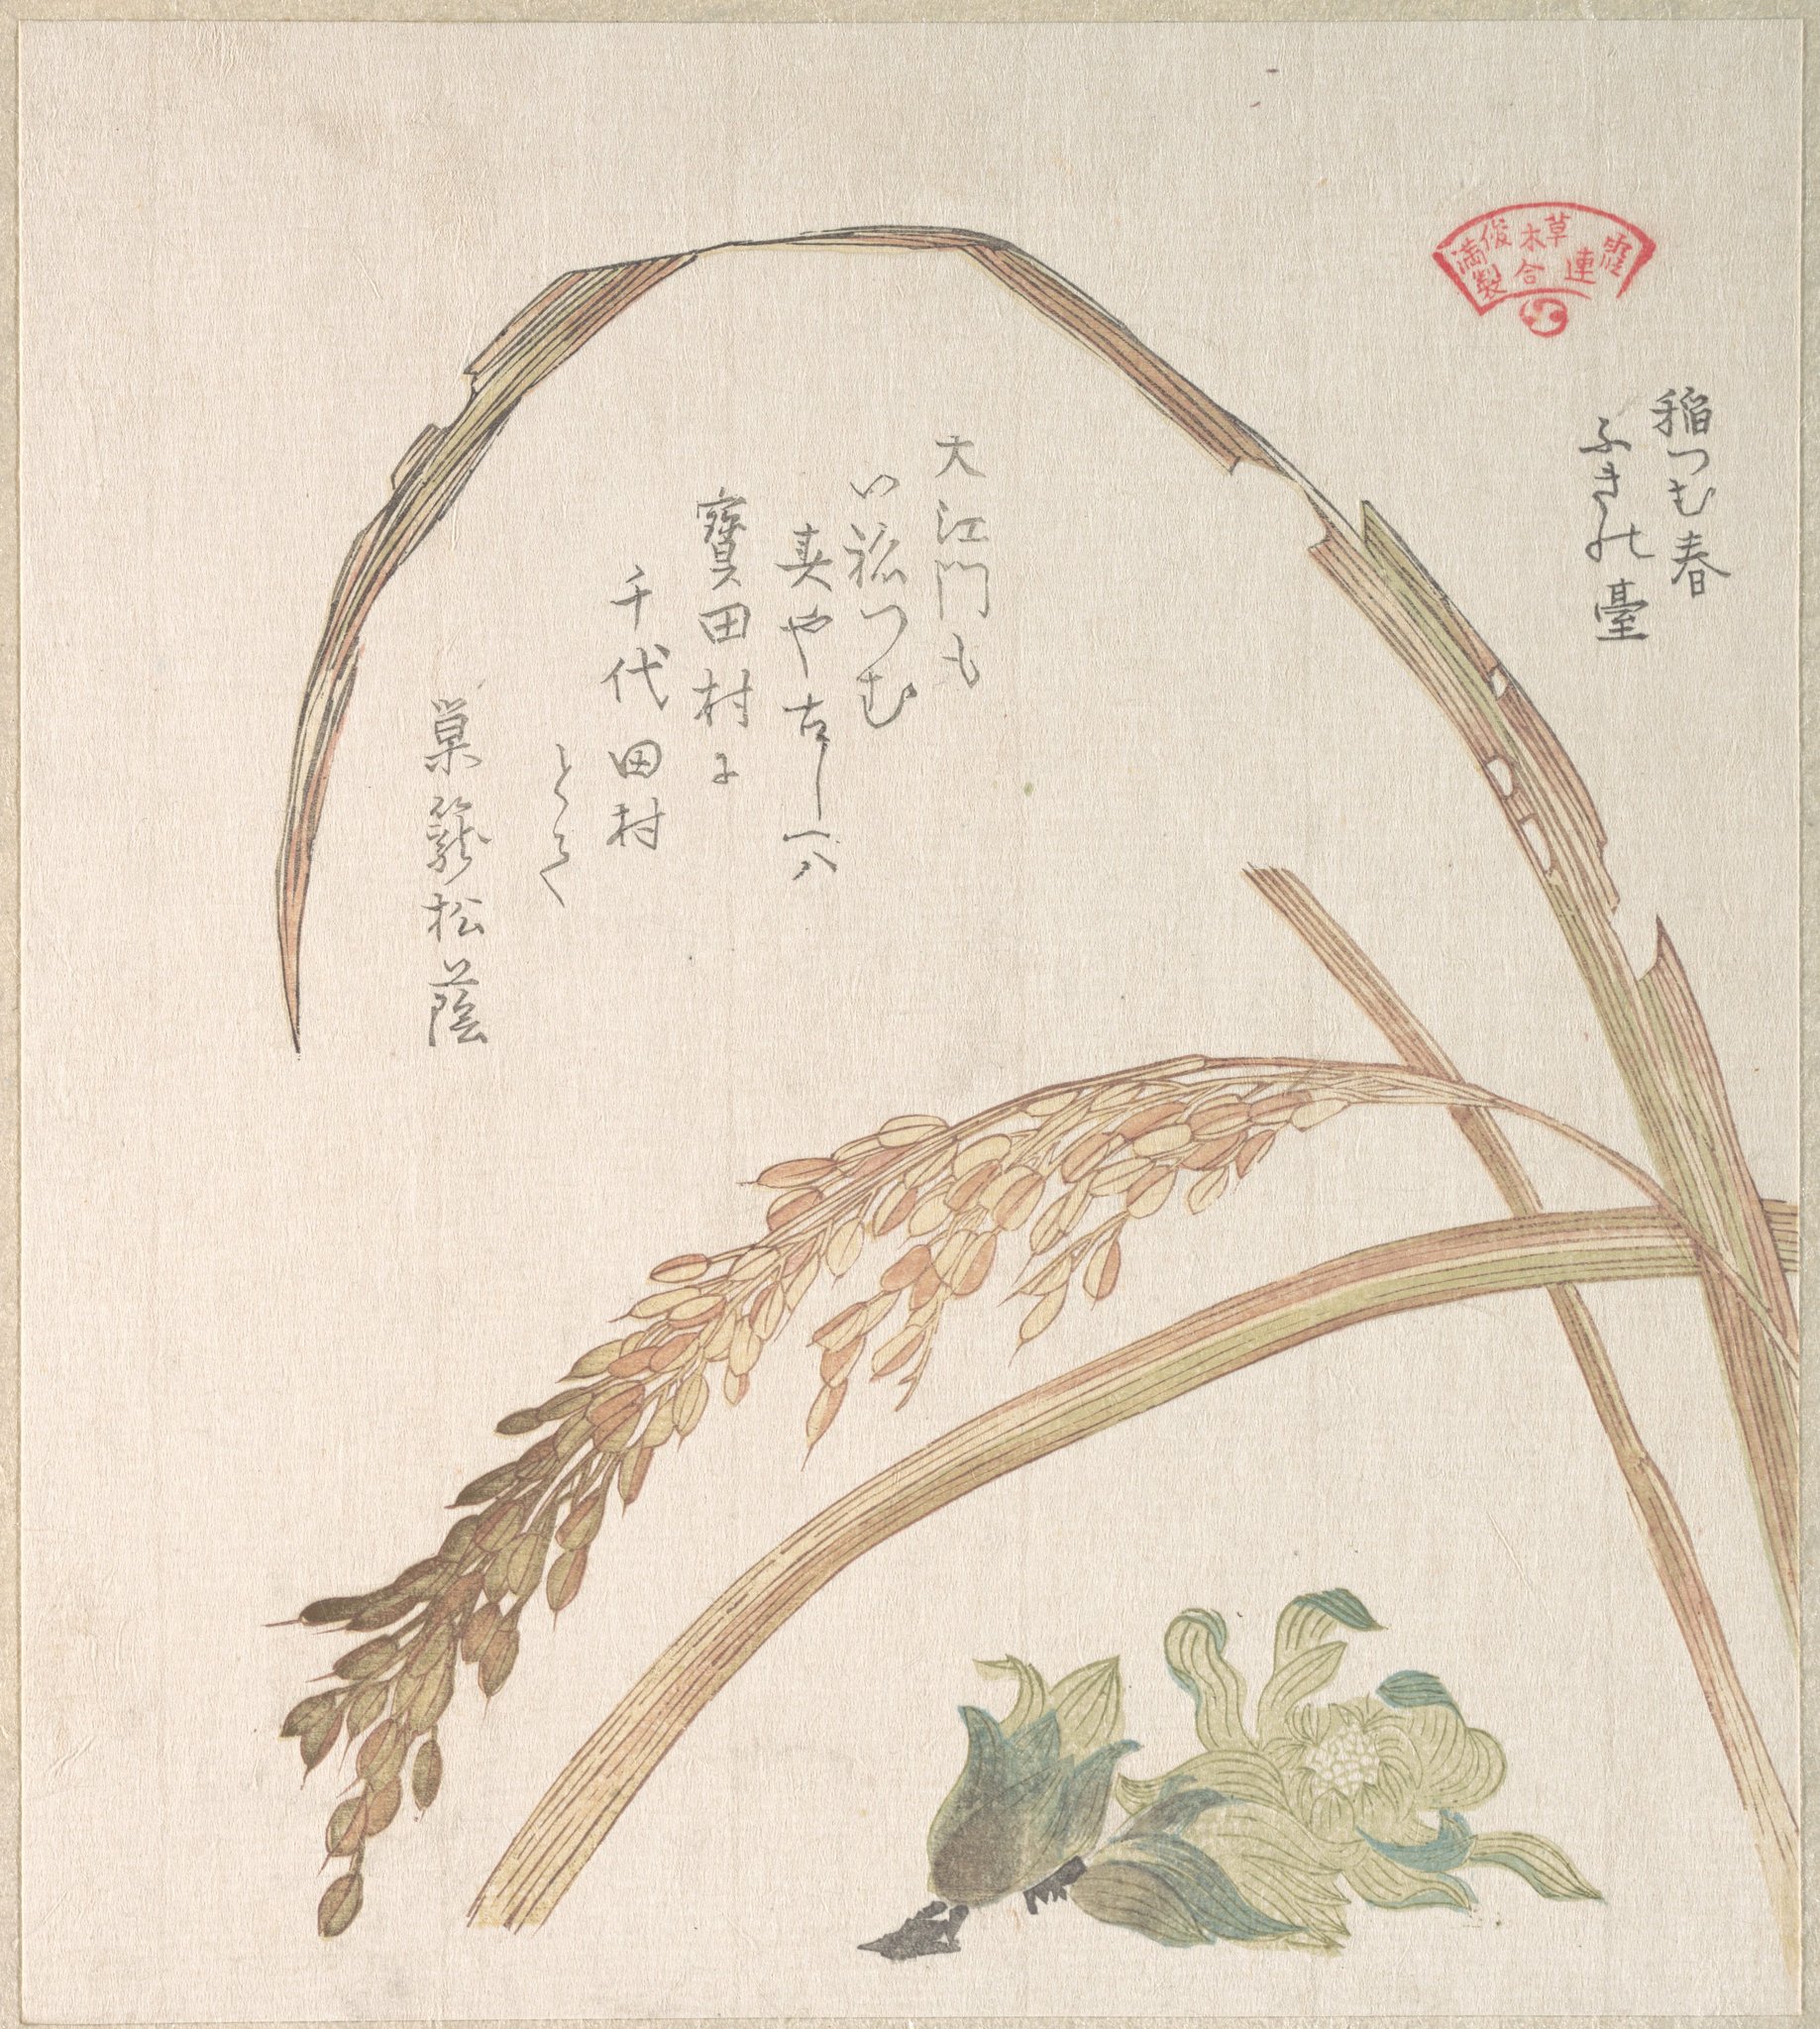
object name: print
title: Rice Plant and Butter-Burs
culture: japanese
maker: kubo shunman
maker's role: artist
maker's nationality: japanese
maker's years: 1757-1820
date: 1801-1900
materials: ink, paper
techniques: surimono, woodblock print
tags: flowers,plants